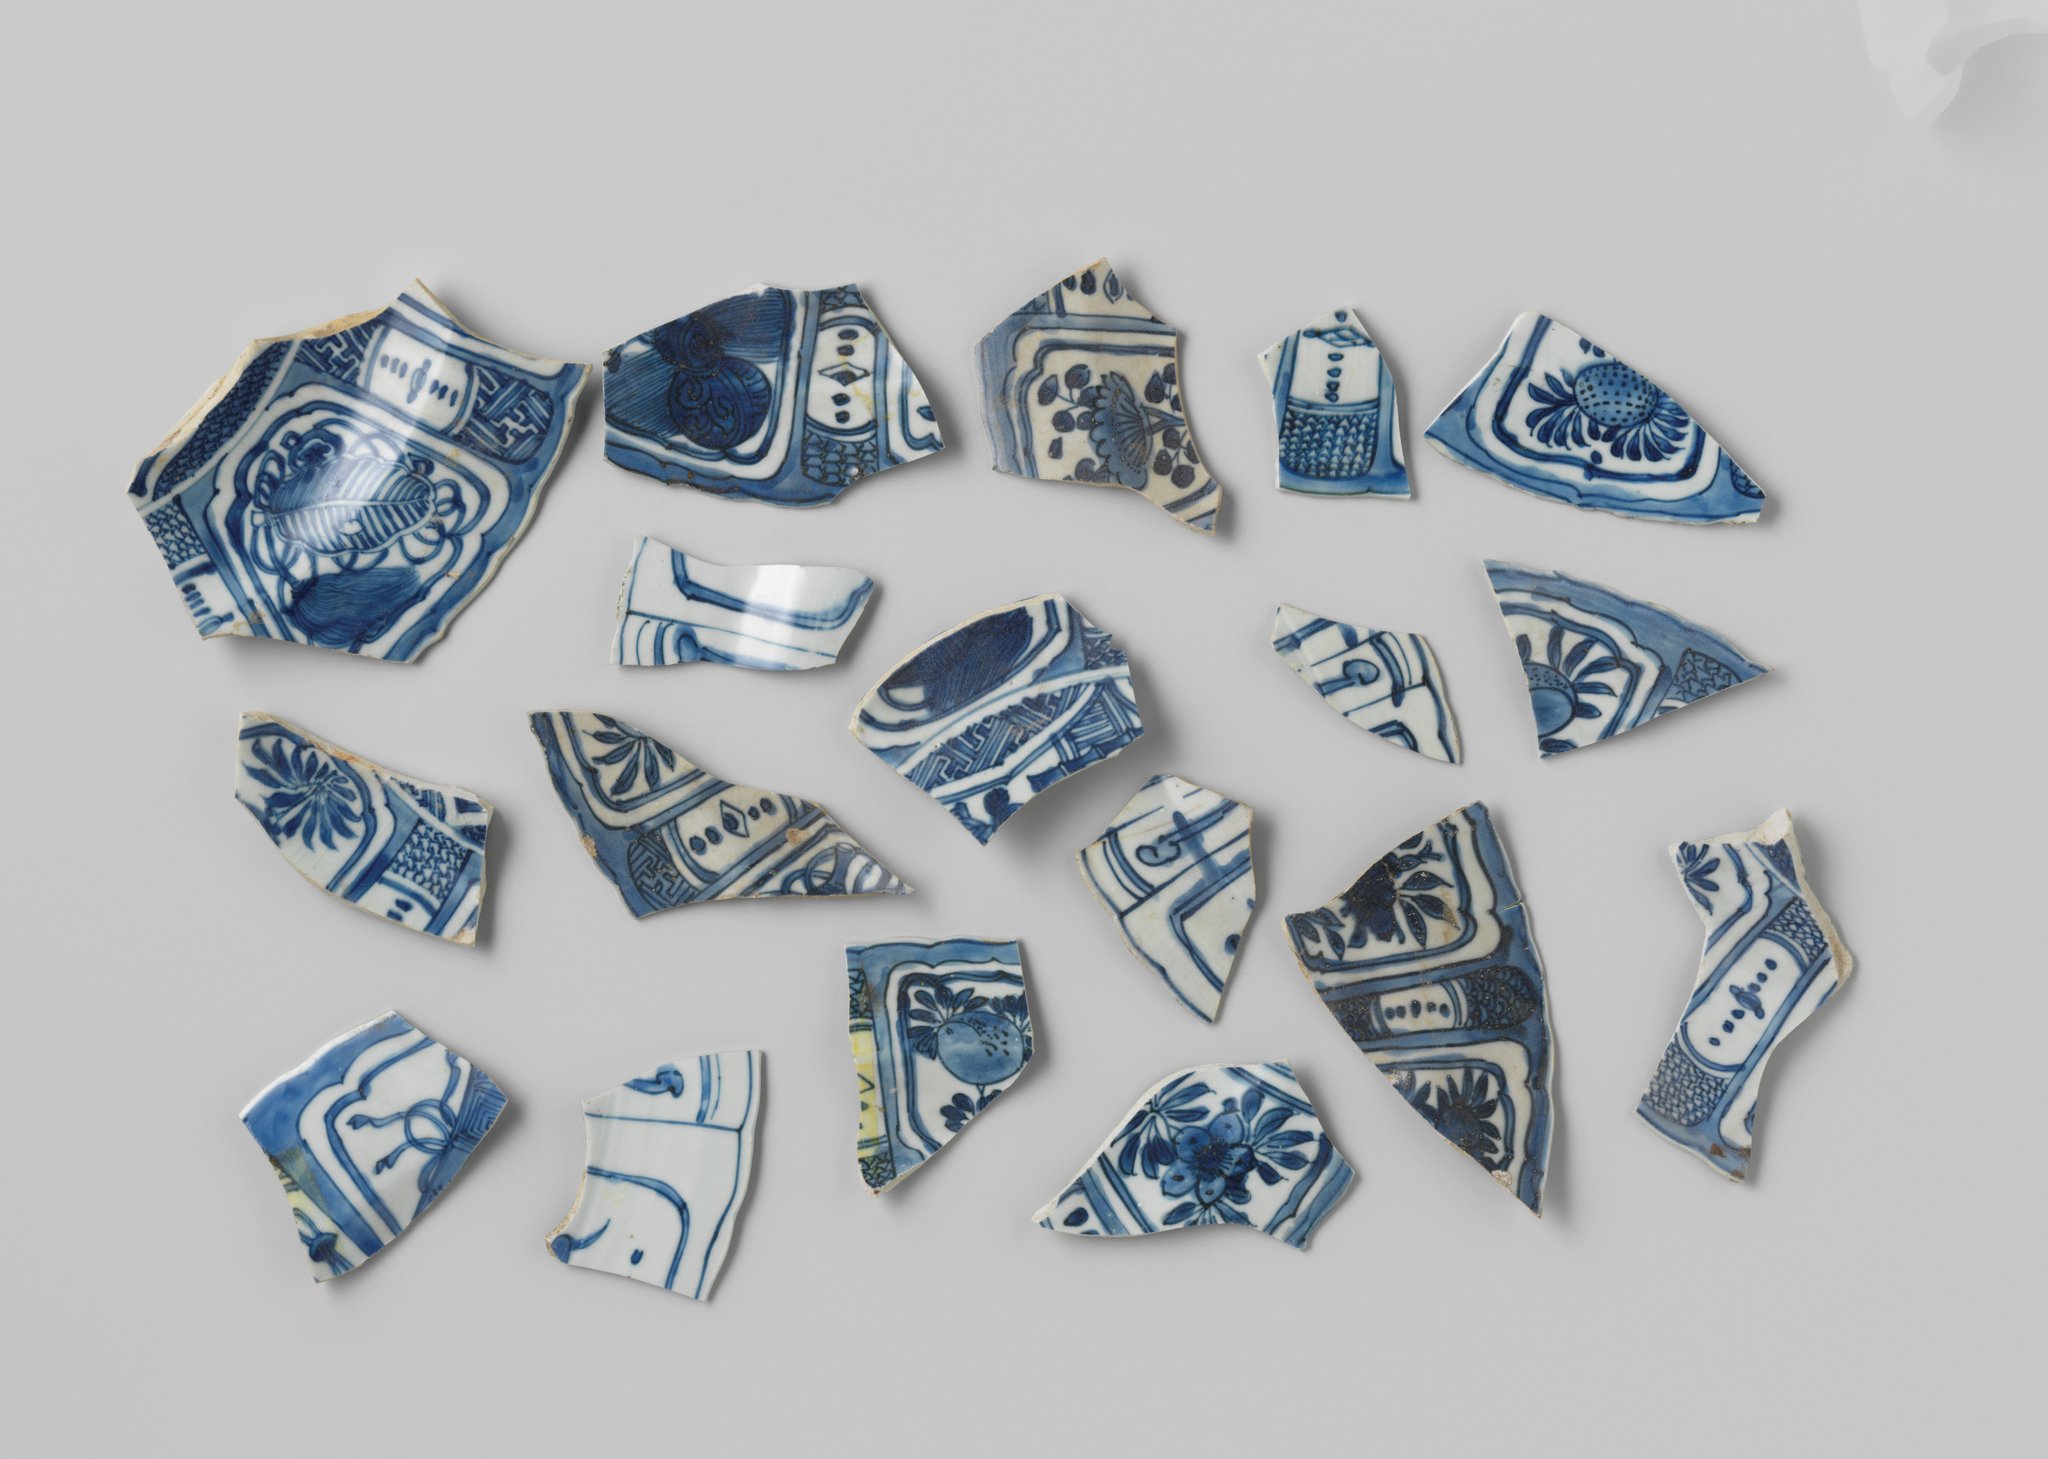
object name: sherd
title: Scherven van borden uit V.O.C.-schip de 'Witte Leeuw'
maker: Anonymous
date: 1613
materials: bone china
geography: jingdezhen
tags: verenigde oostindische compagnie, sint-helena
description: Scherven van borden uit V.O.C.-schip de 'Witte Leeuw' van kraakporselein.